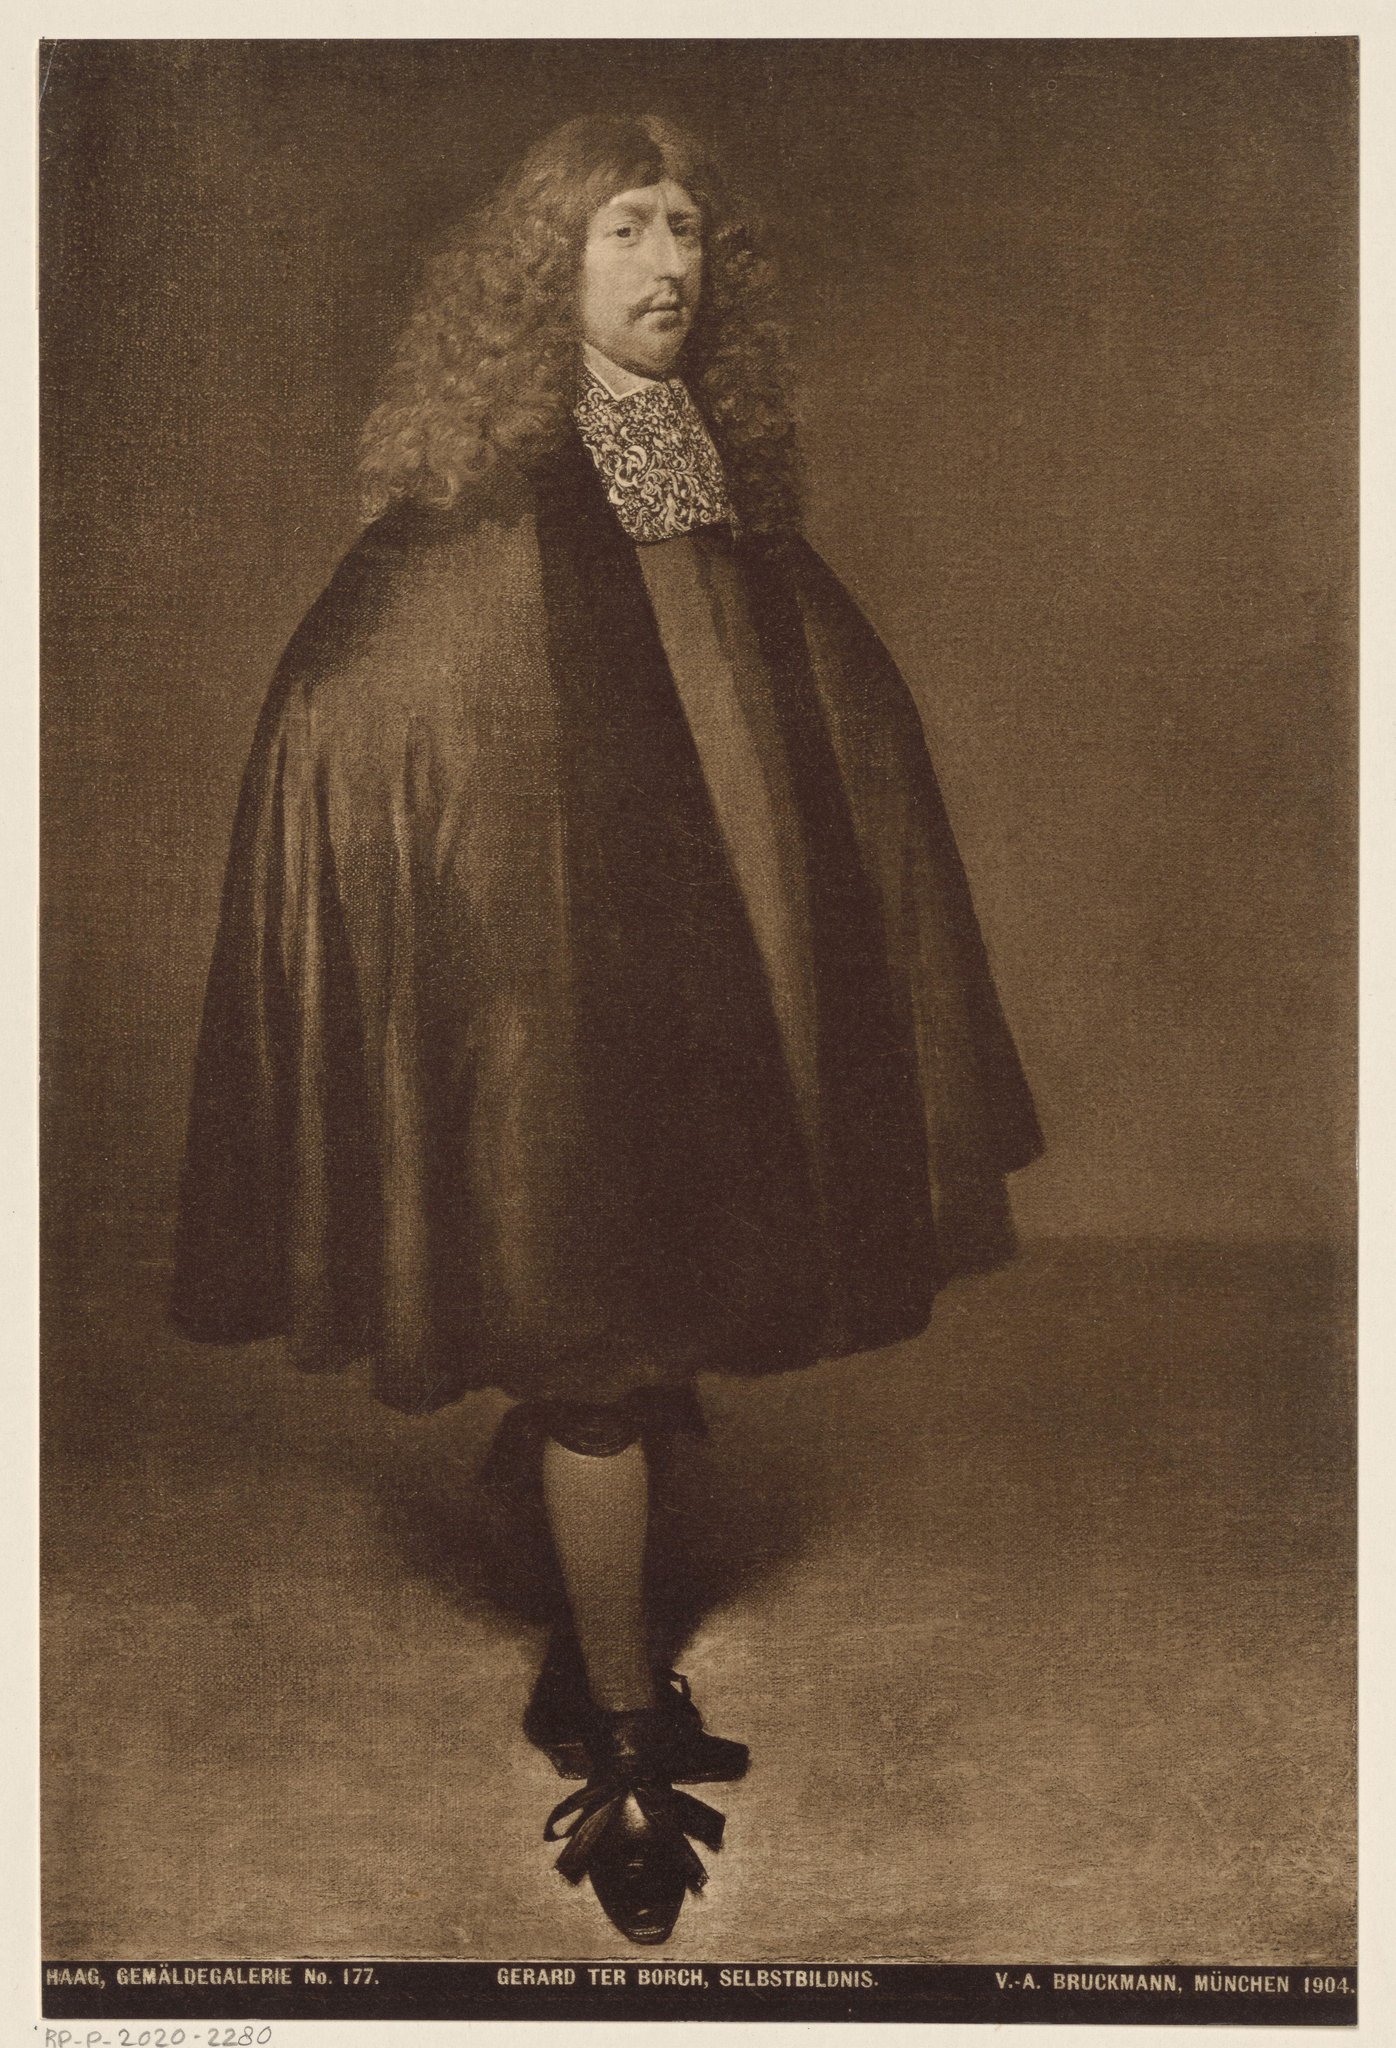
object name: photomechanical print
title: Portret van Gerard ter Borch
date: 1904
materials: paper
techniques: photograph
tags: deventer, painter, draughtsman, gerard ter borch (ii), historical persons, portrait, self-portrait of painter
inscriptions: date